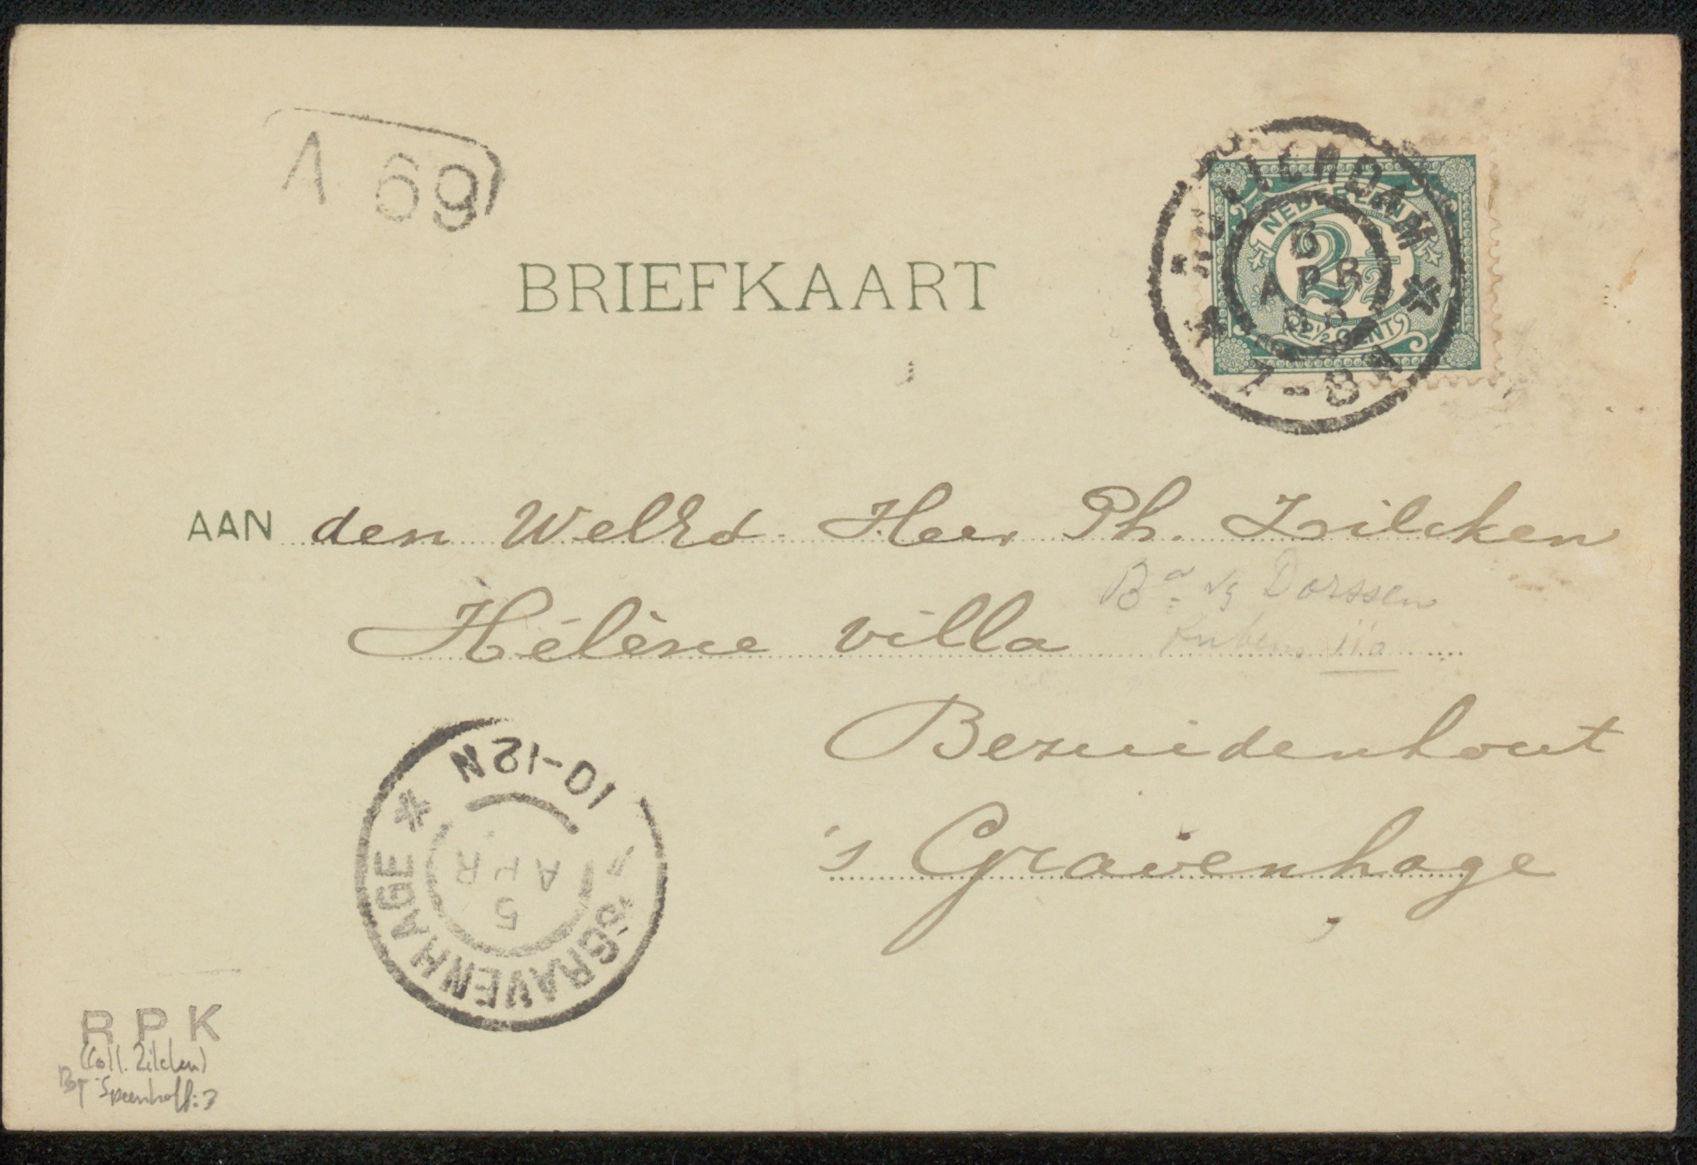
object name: postcard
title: Briefkaart aan Philip Zilcken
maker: jacobus hendrikus speenhoff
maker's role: painter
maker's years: 1869-1945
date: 1903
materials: cardboard, ink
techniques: pen, writing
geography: rotterdam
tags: draughtsman, philip zilcken, drawing, illustration ~ printed matter, book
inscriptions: collector's mark: ‘RPK’